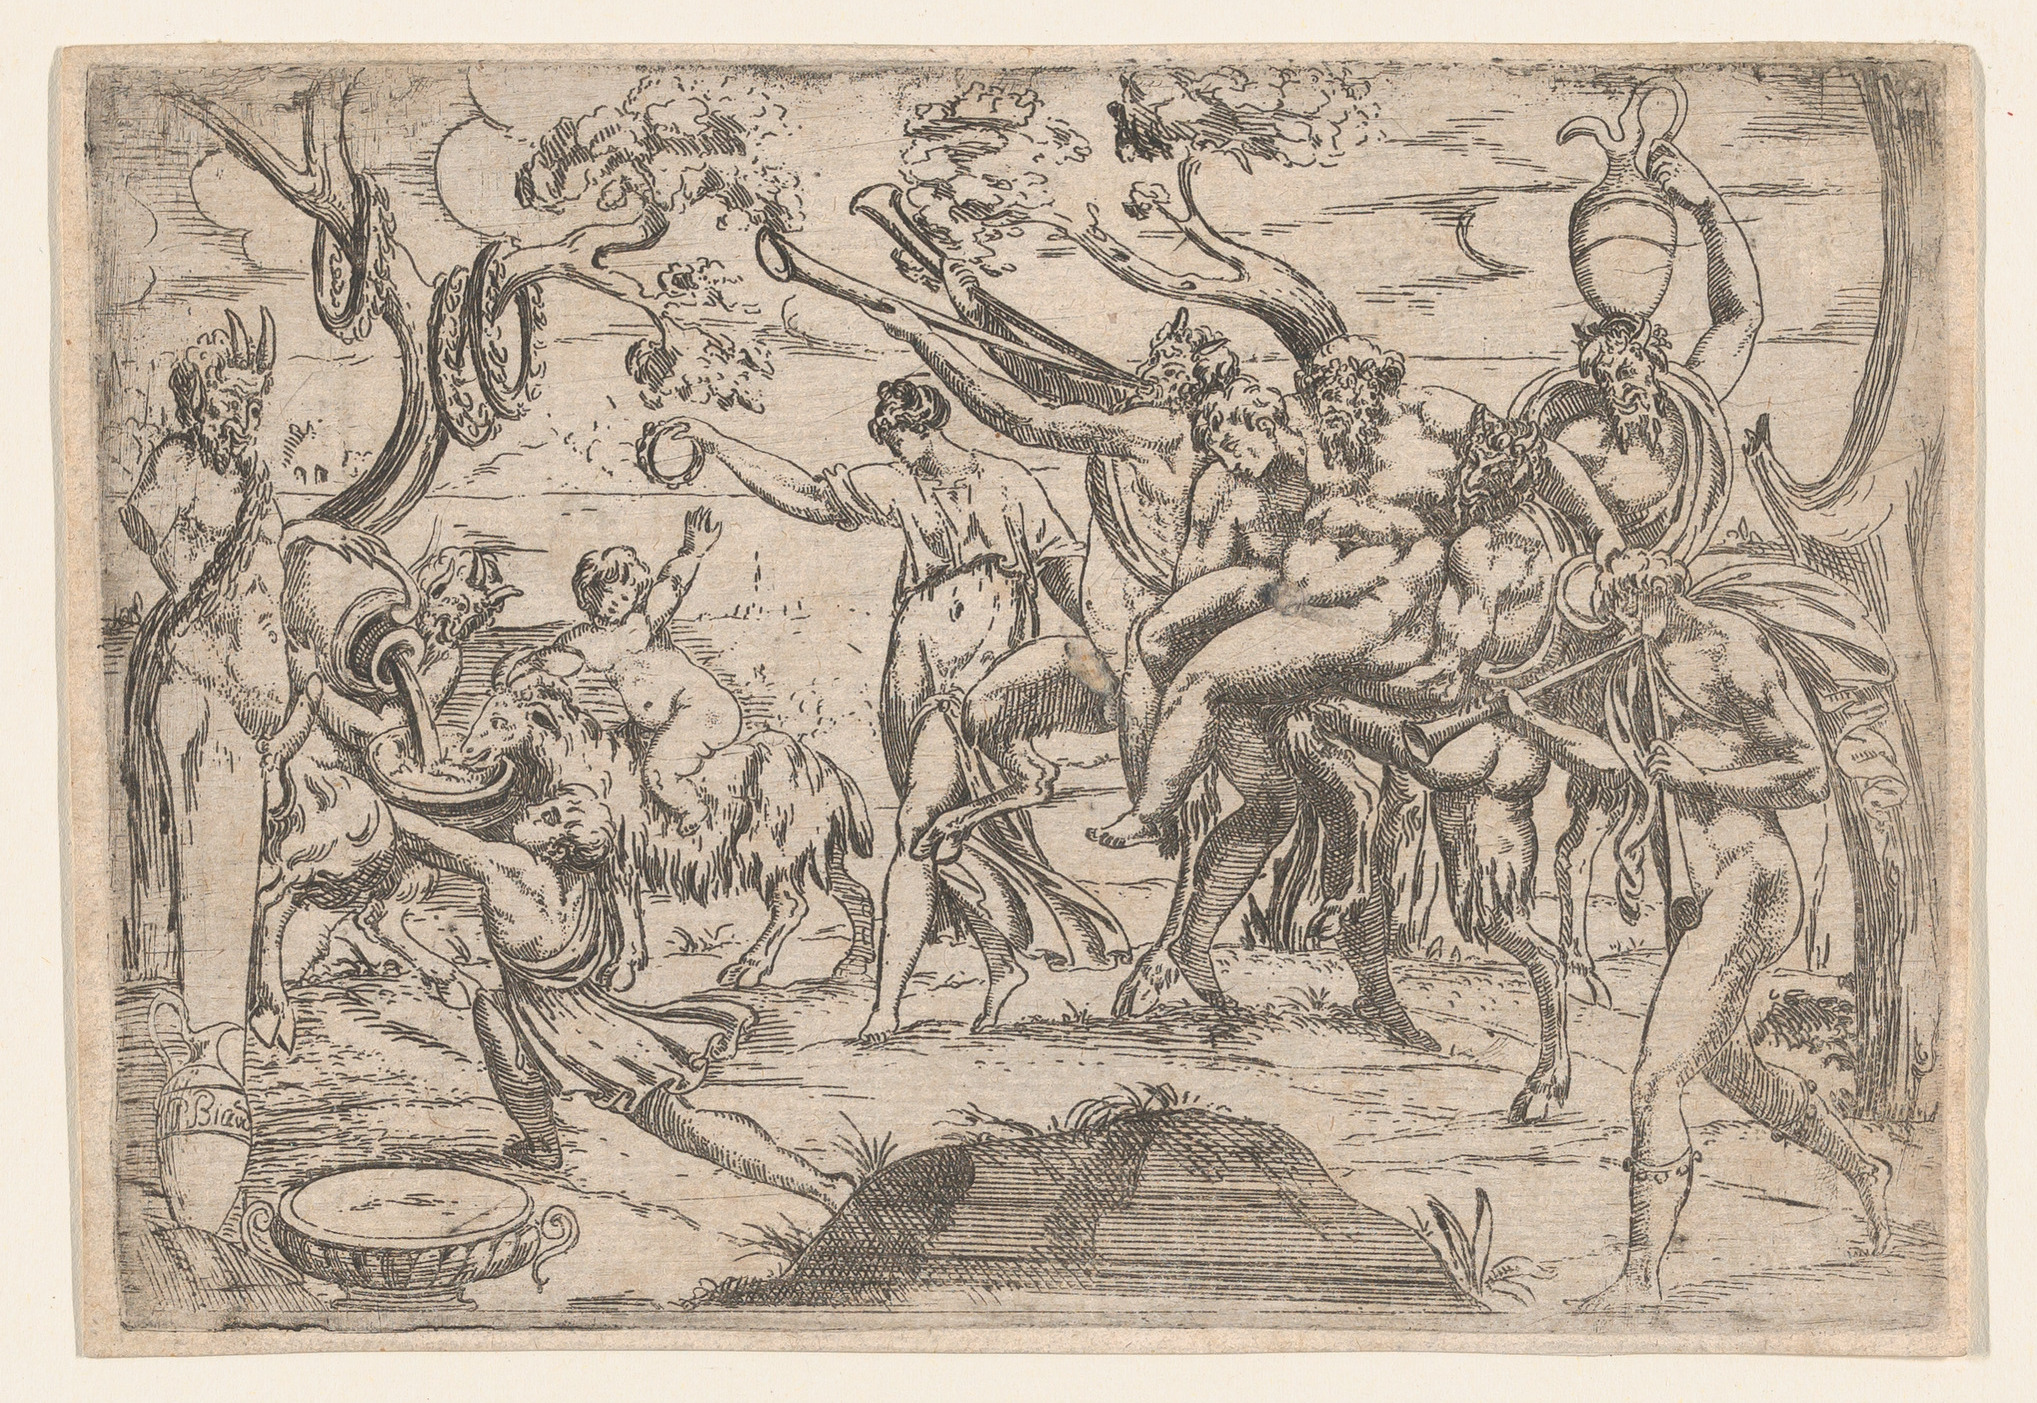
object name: print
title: Triumph of Silenus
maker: pierre biard ii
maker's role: artist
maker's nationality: french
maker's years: 1592-1661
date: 1607-1661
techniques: engraving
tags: musical instruments,silenus,satyrs